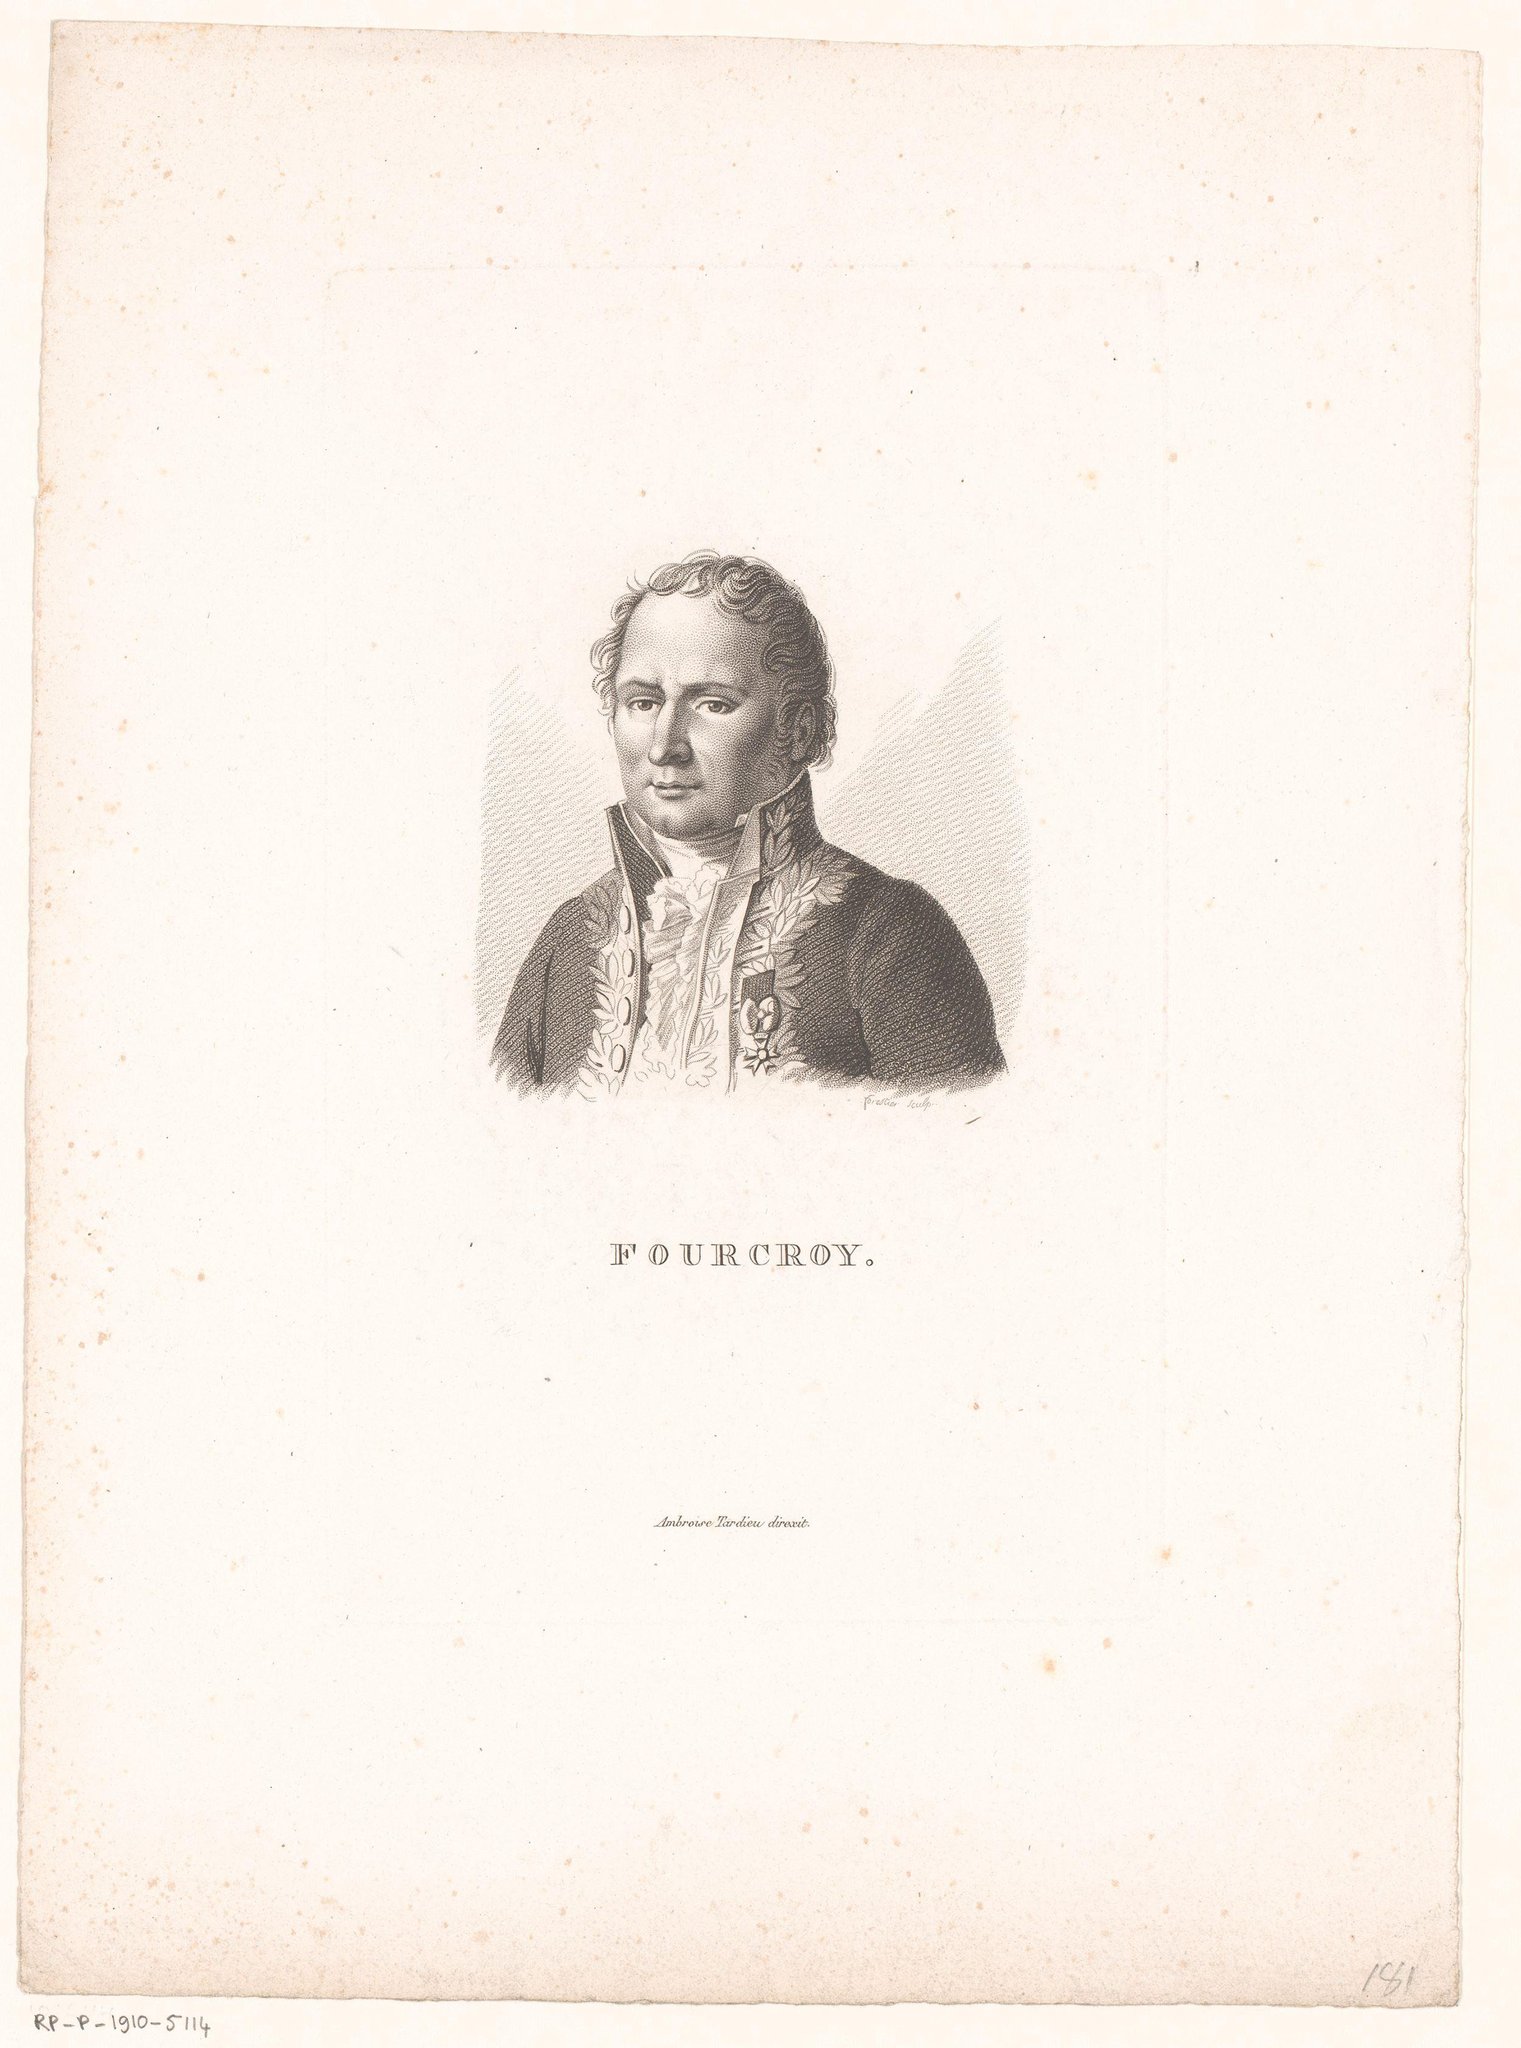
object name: book illustration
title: Portret van Antoine François de Fourcroy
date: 1818-1832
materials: paper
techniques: engraving, roulette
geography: france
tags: paris, politician, scholar, philosopher, historical persons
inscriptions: collector's mark: Lugt 2228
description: Mogelijk prent uit: Journal complémentaire du Dictionnaire des sciences médicales. Parijs: Panckoucke, Charles Louis Fleury, 1818-1832.